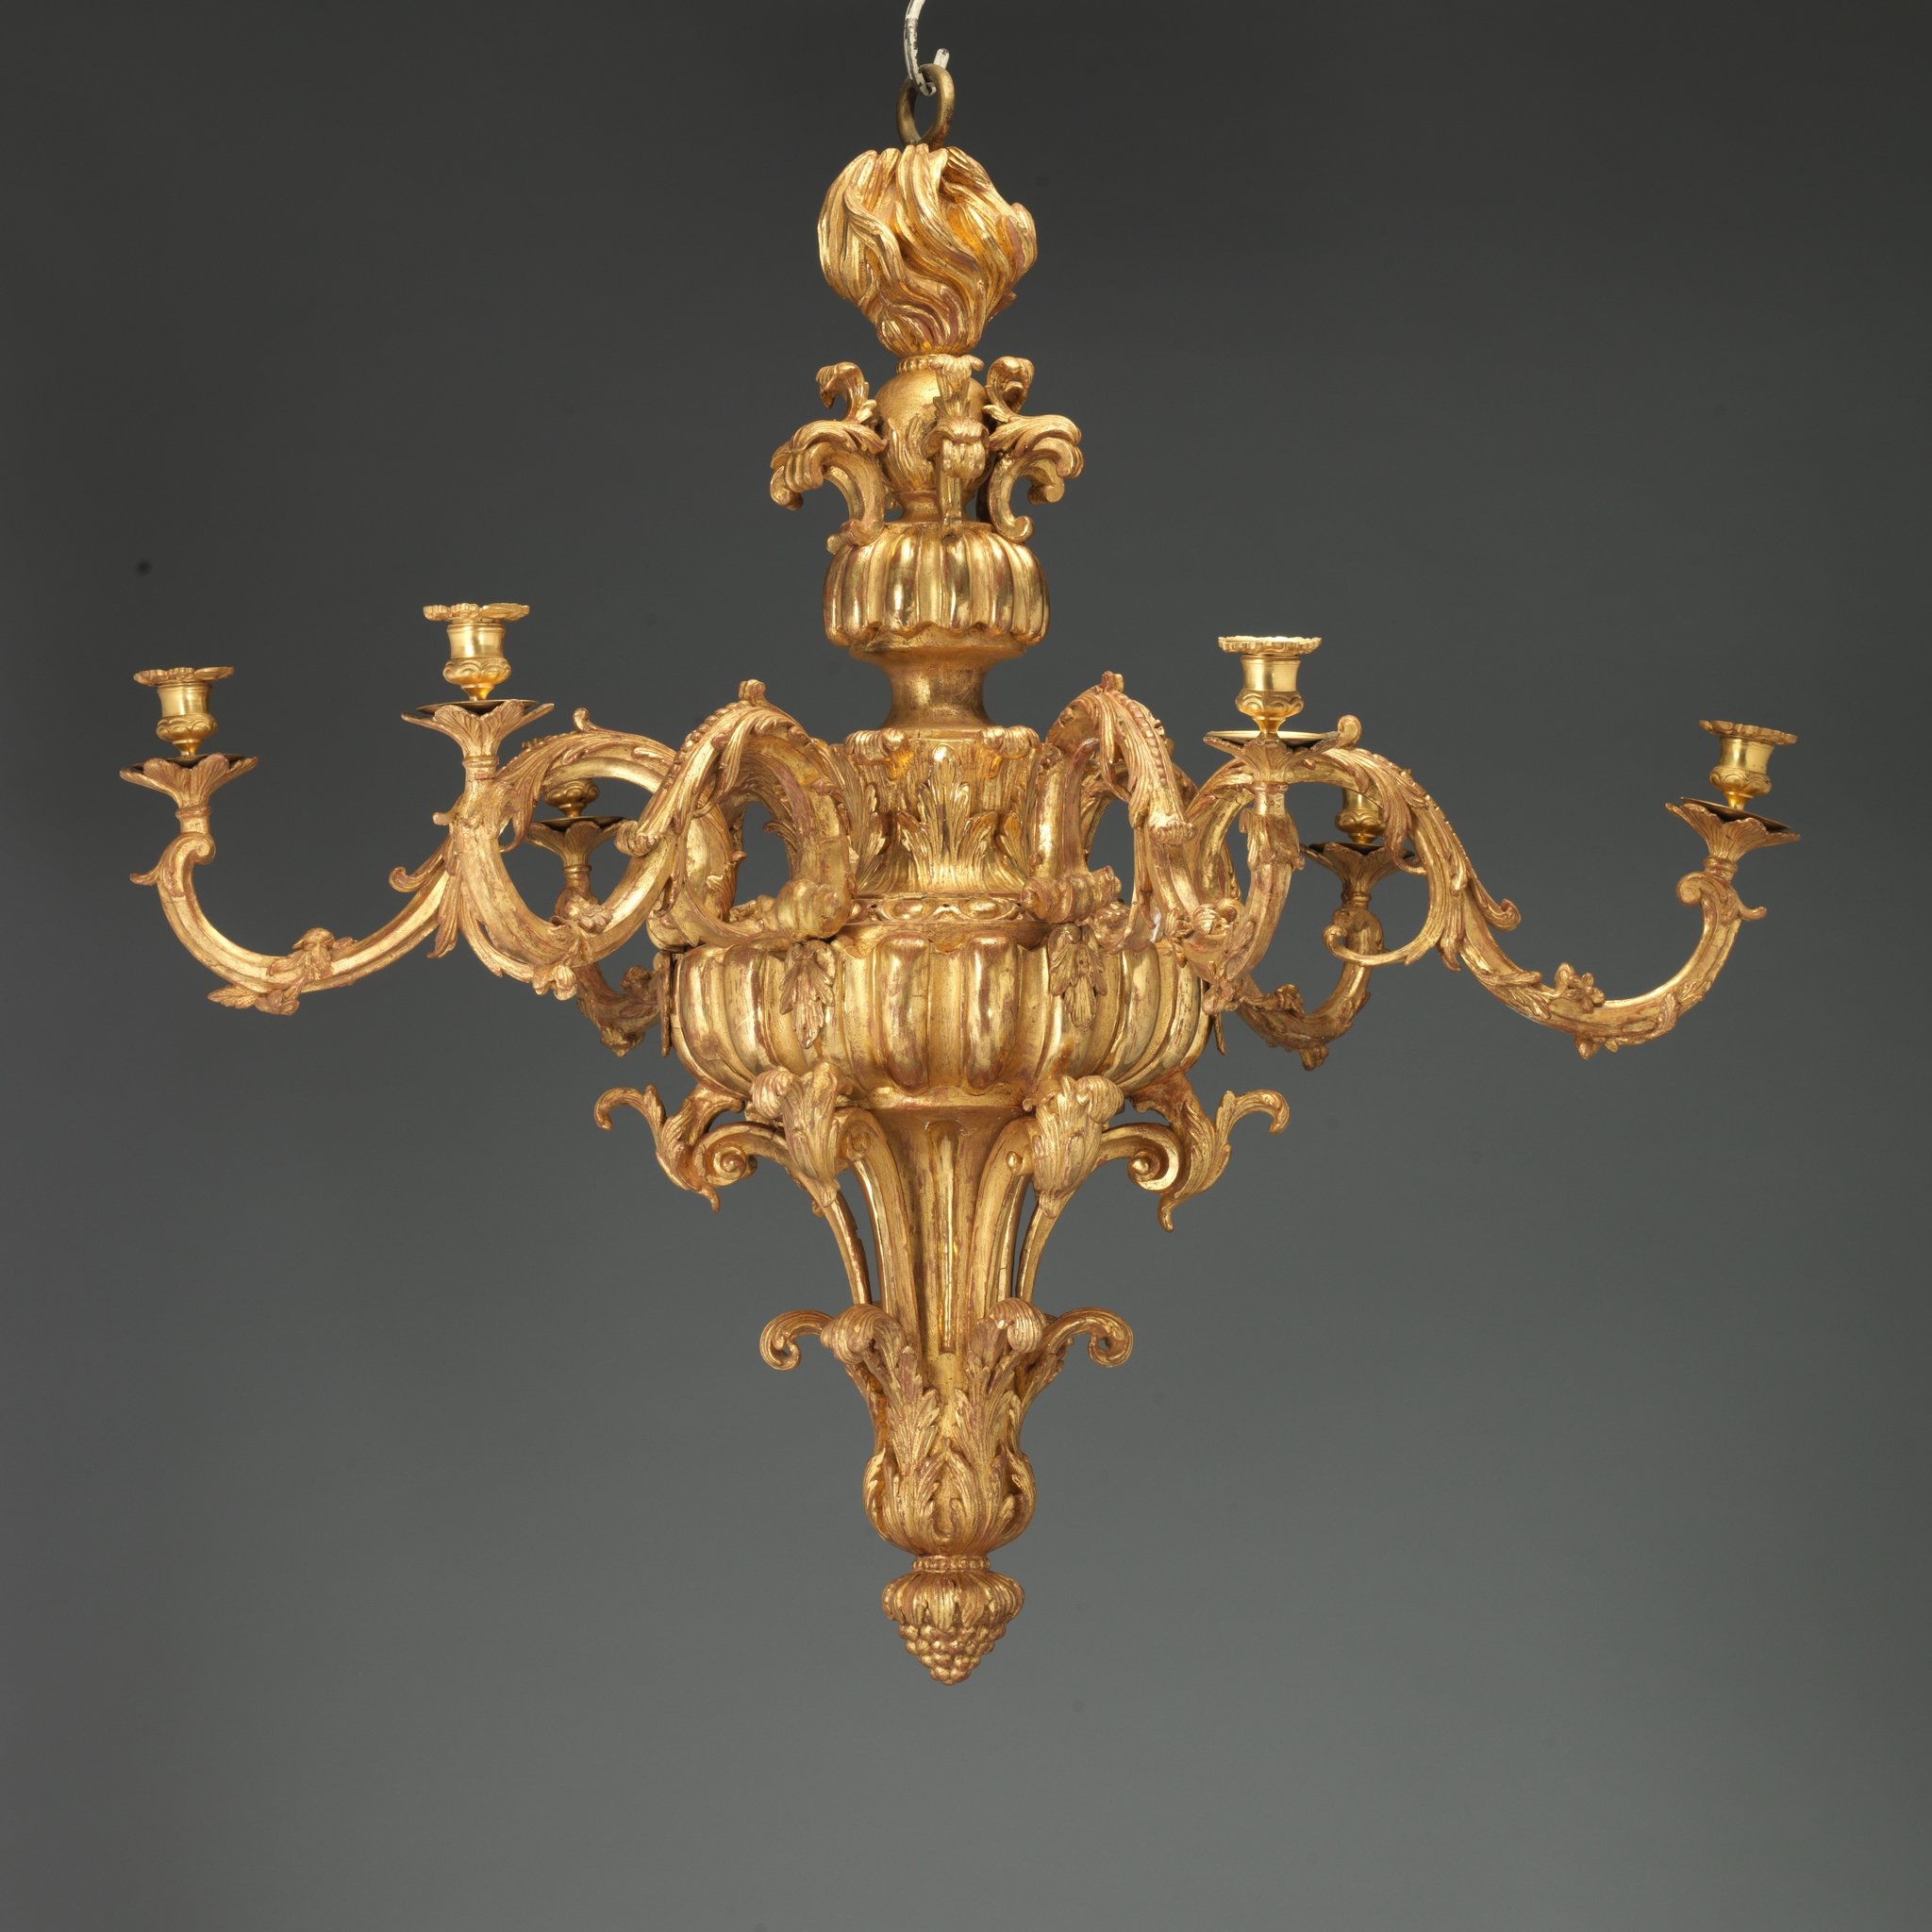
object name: chandelier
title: Six-branch chandelier (one of a pair)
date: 1725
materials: gesso, gilt bronze, wood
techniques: gilding